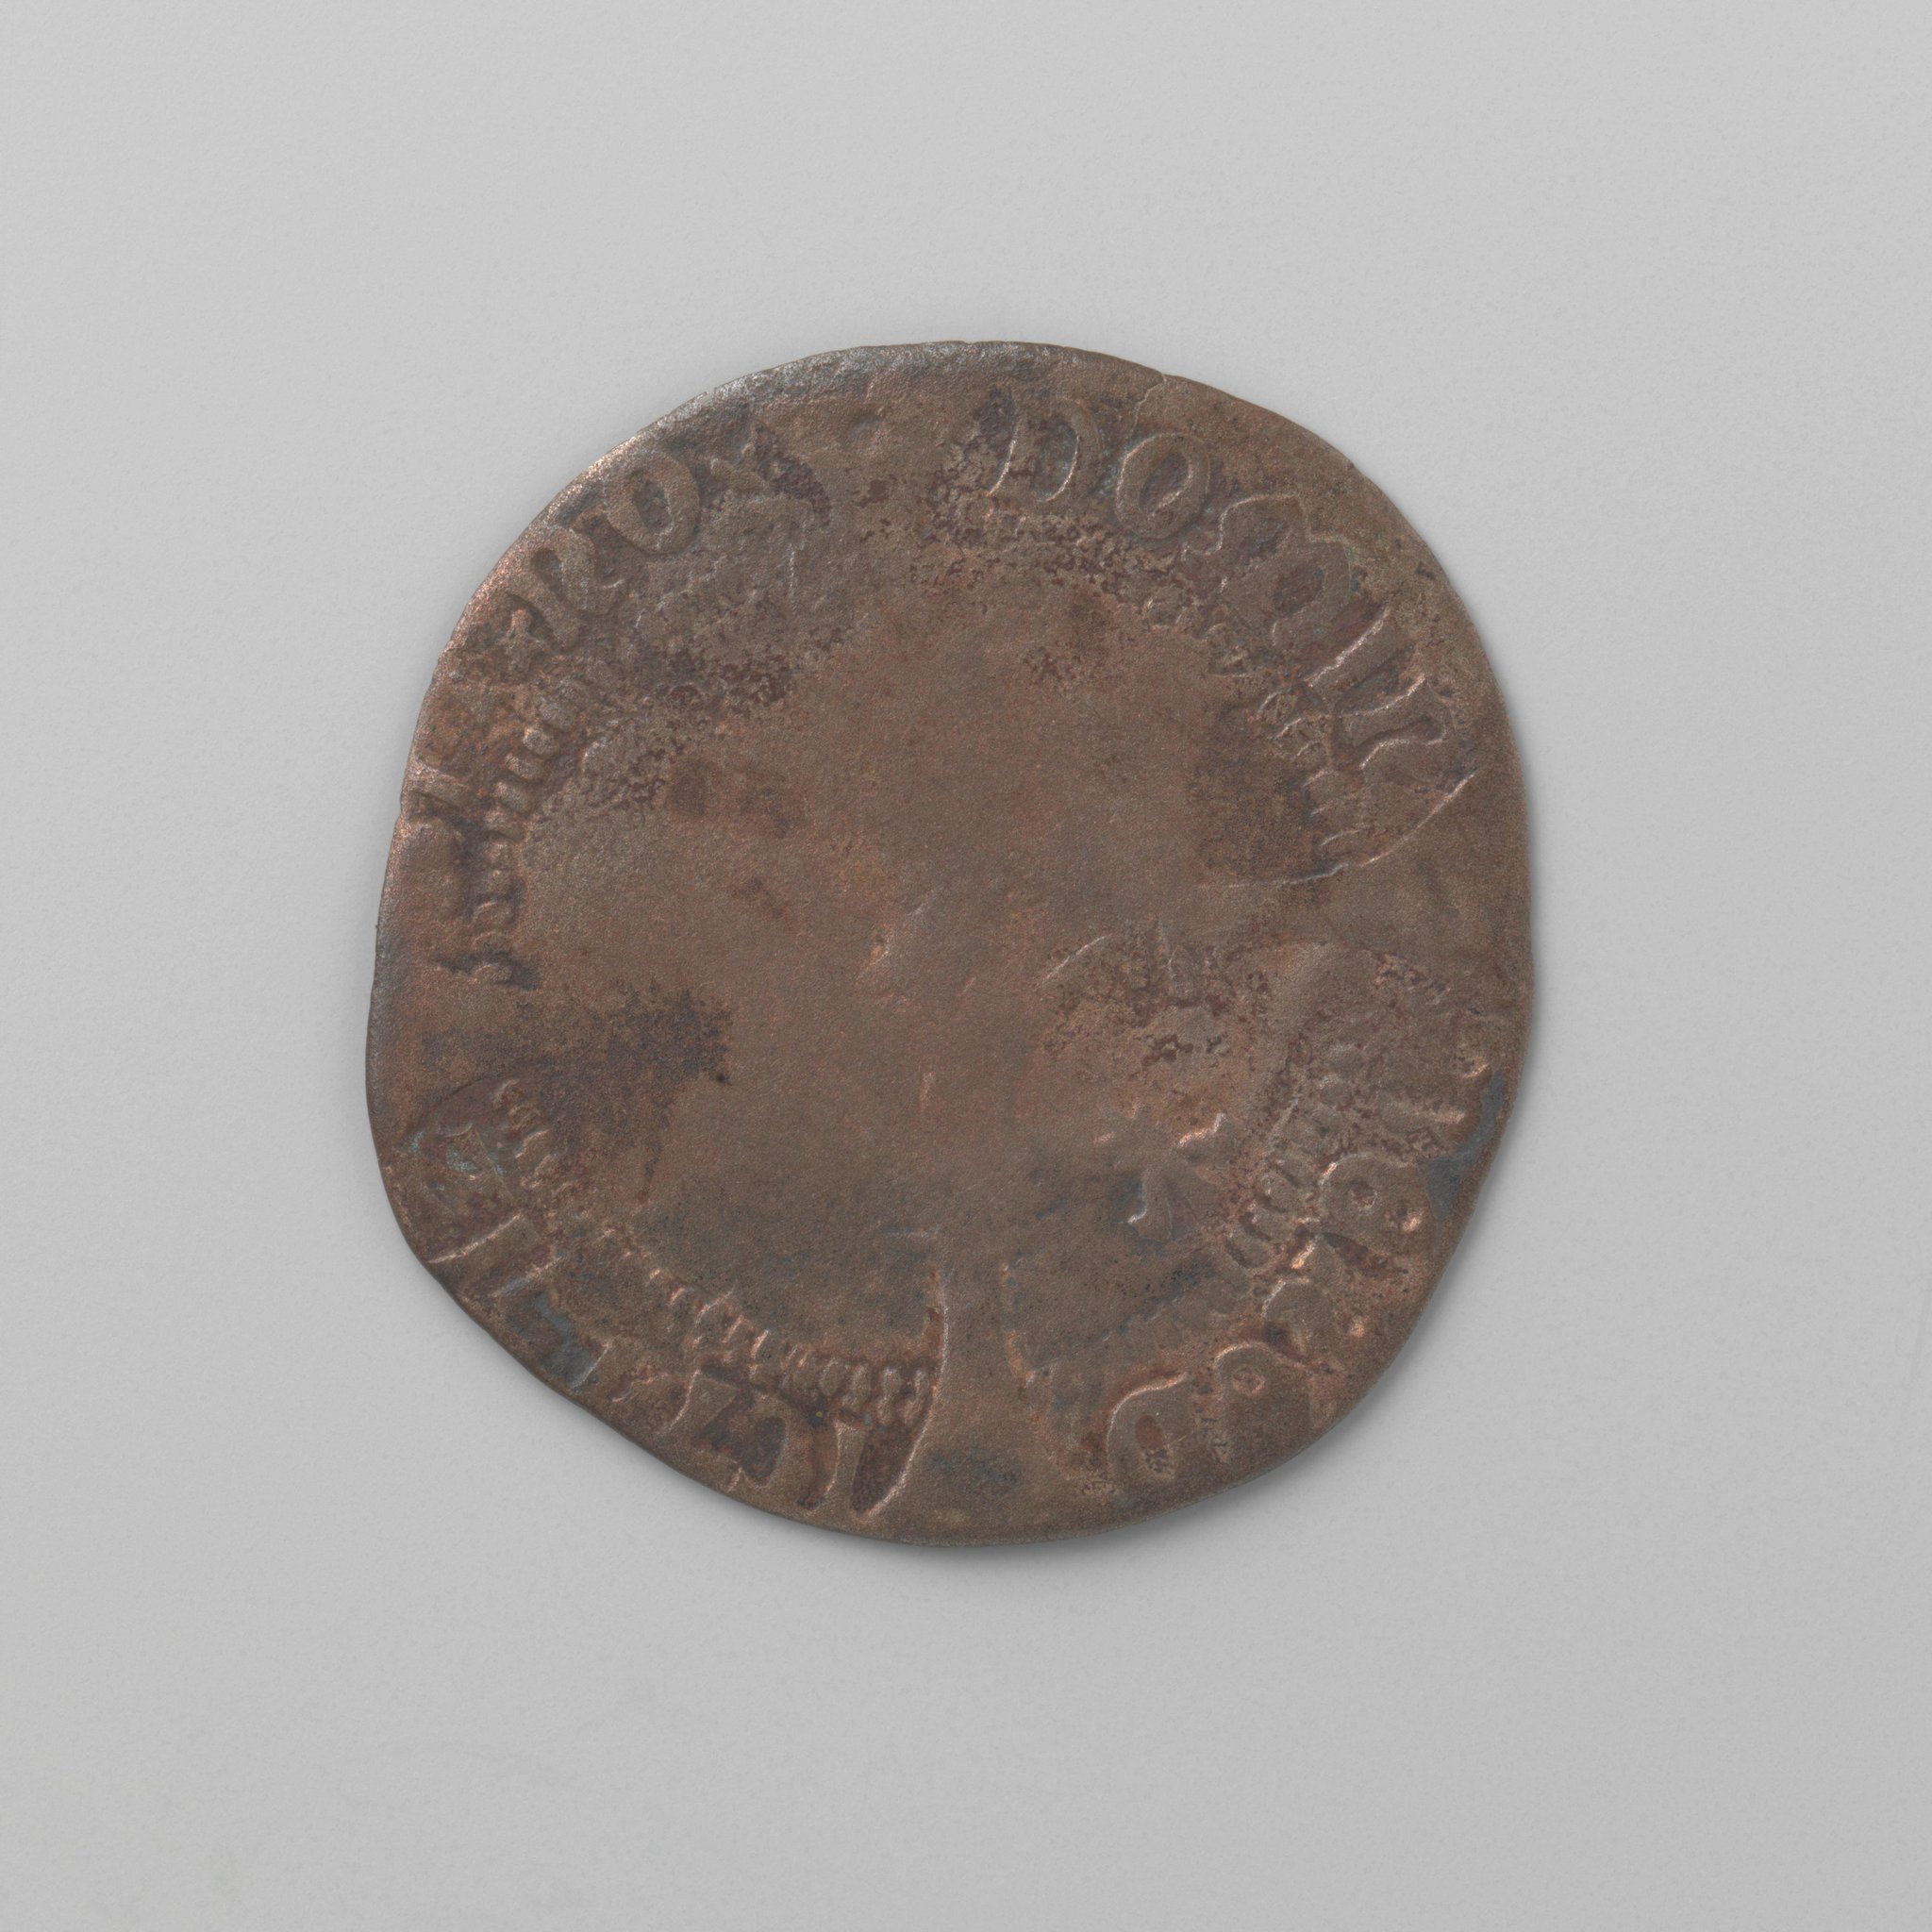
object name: coin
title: Groot van keizer Karel V, hertog van Brabant, 1512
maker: hertog van brabant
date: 1512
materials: silver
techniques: striking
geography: maastricht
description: Zilveren munt. Voorzijde: wapen. Keerzijde: lang versierd kruis, in het hart ster, in de hoeken afwiosselend een lelie en een leeuw.